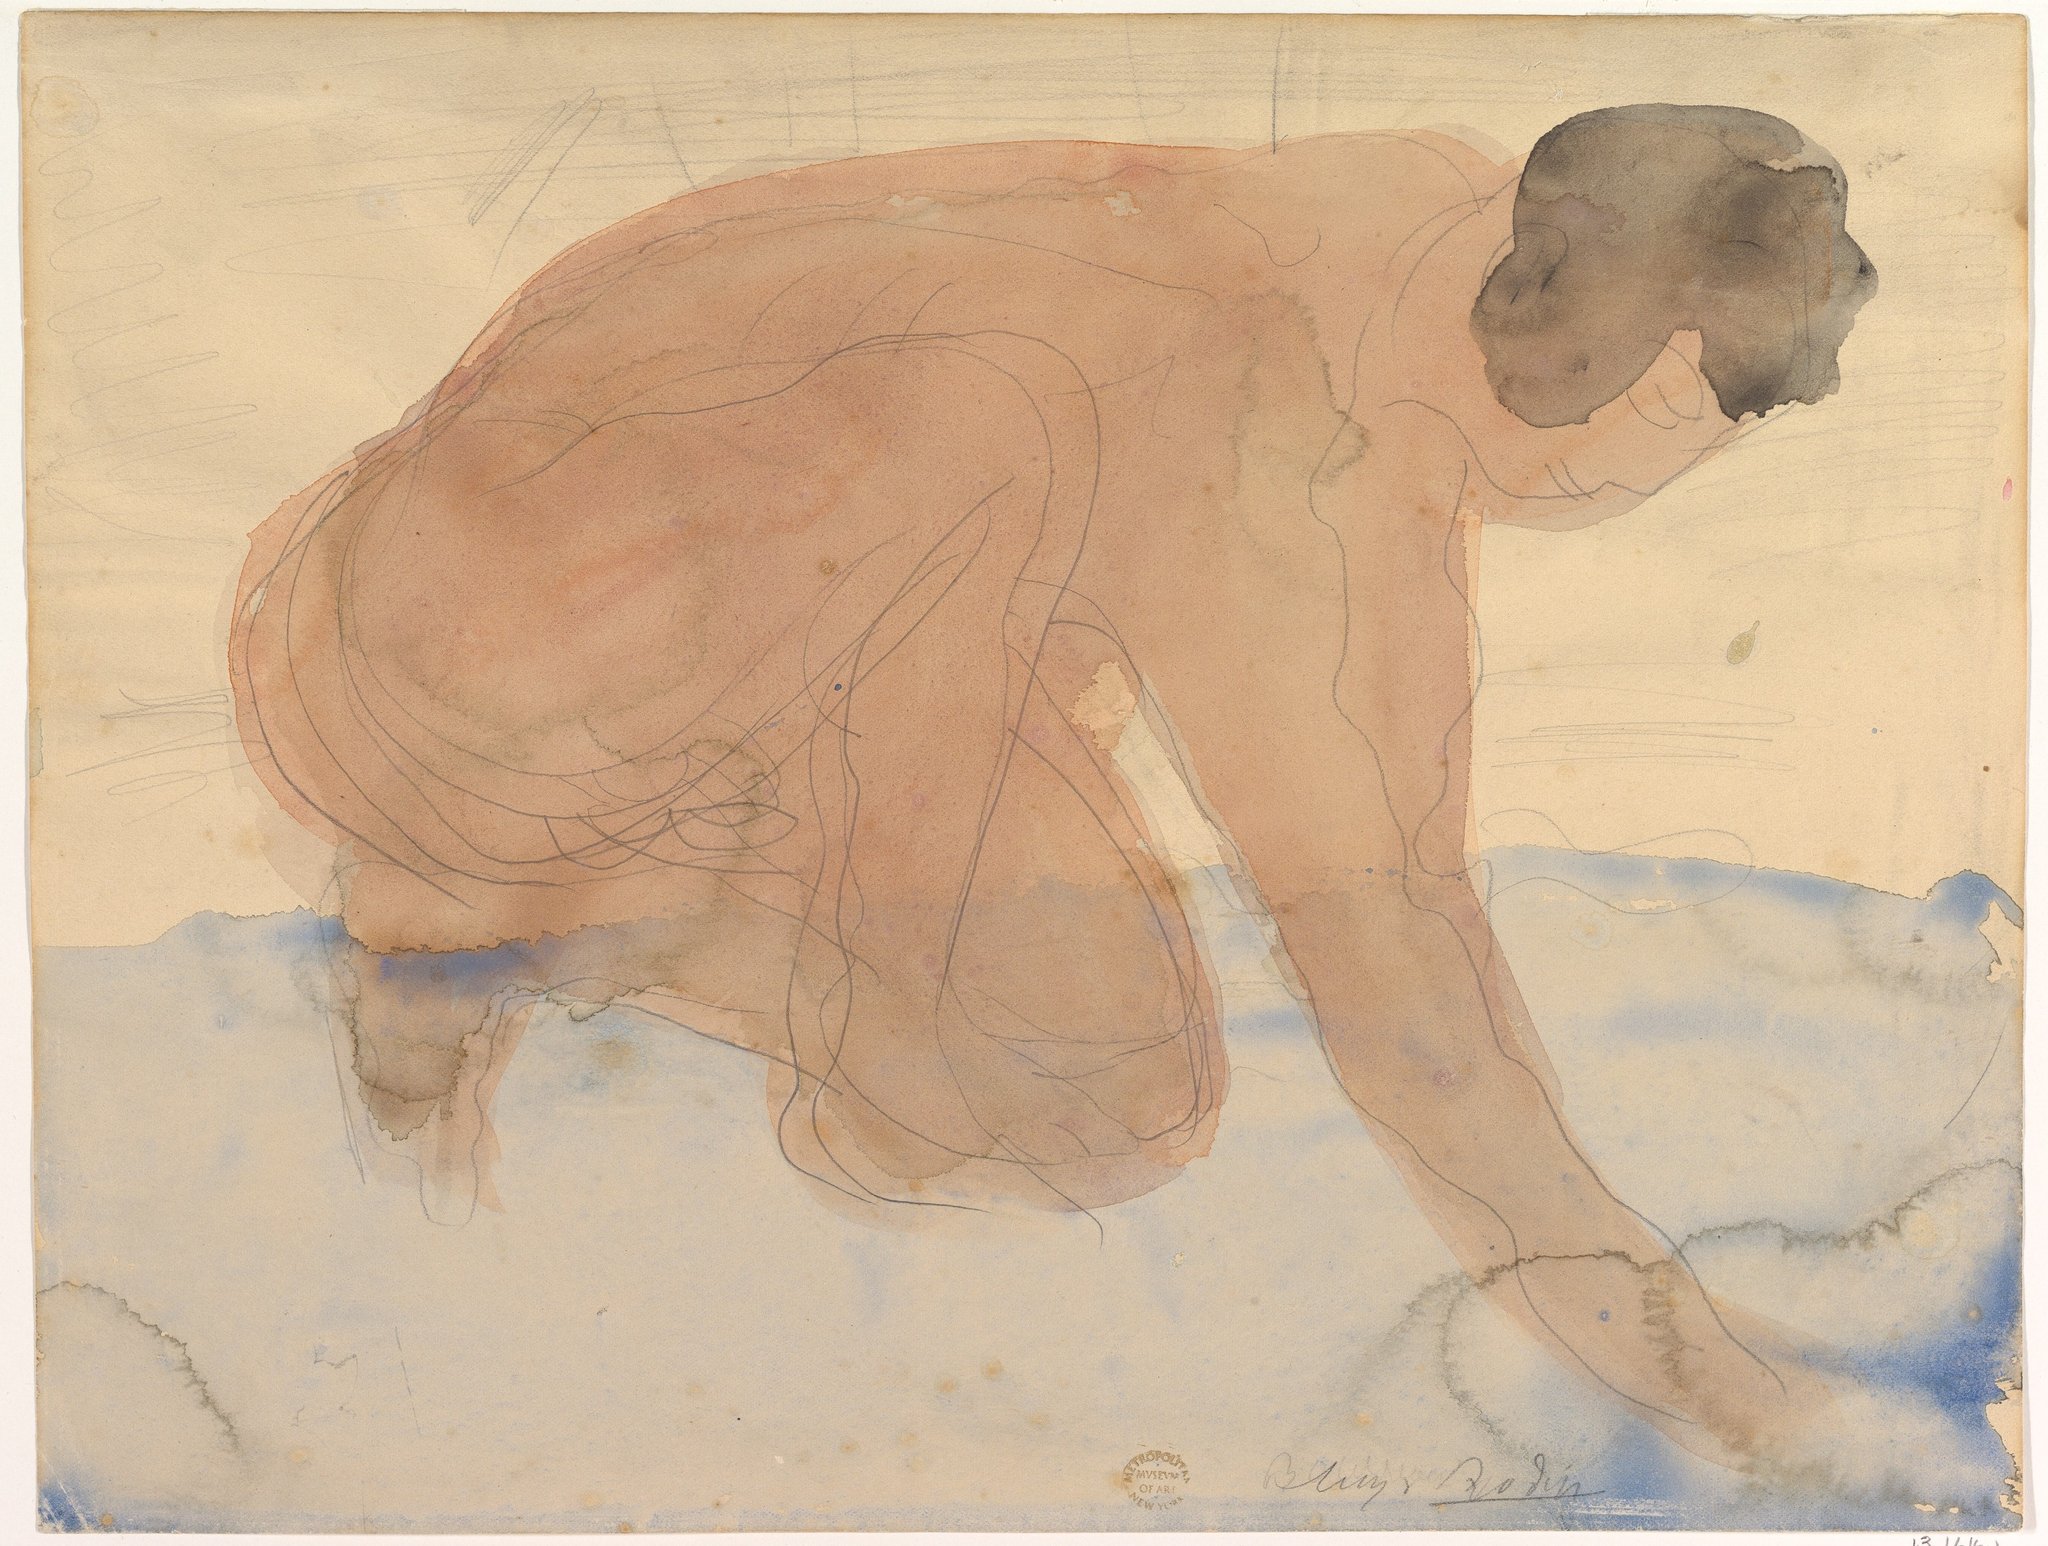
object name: drawing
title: Nude Figure on Hands and Knees (Executioner)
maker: auguste rodin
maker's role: artist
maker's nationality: french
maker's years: 1840-1917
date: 1900-1910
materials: graphite, watercolor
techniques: stumping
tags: men